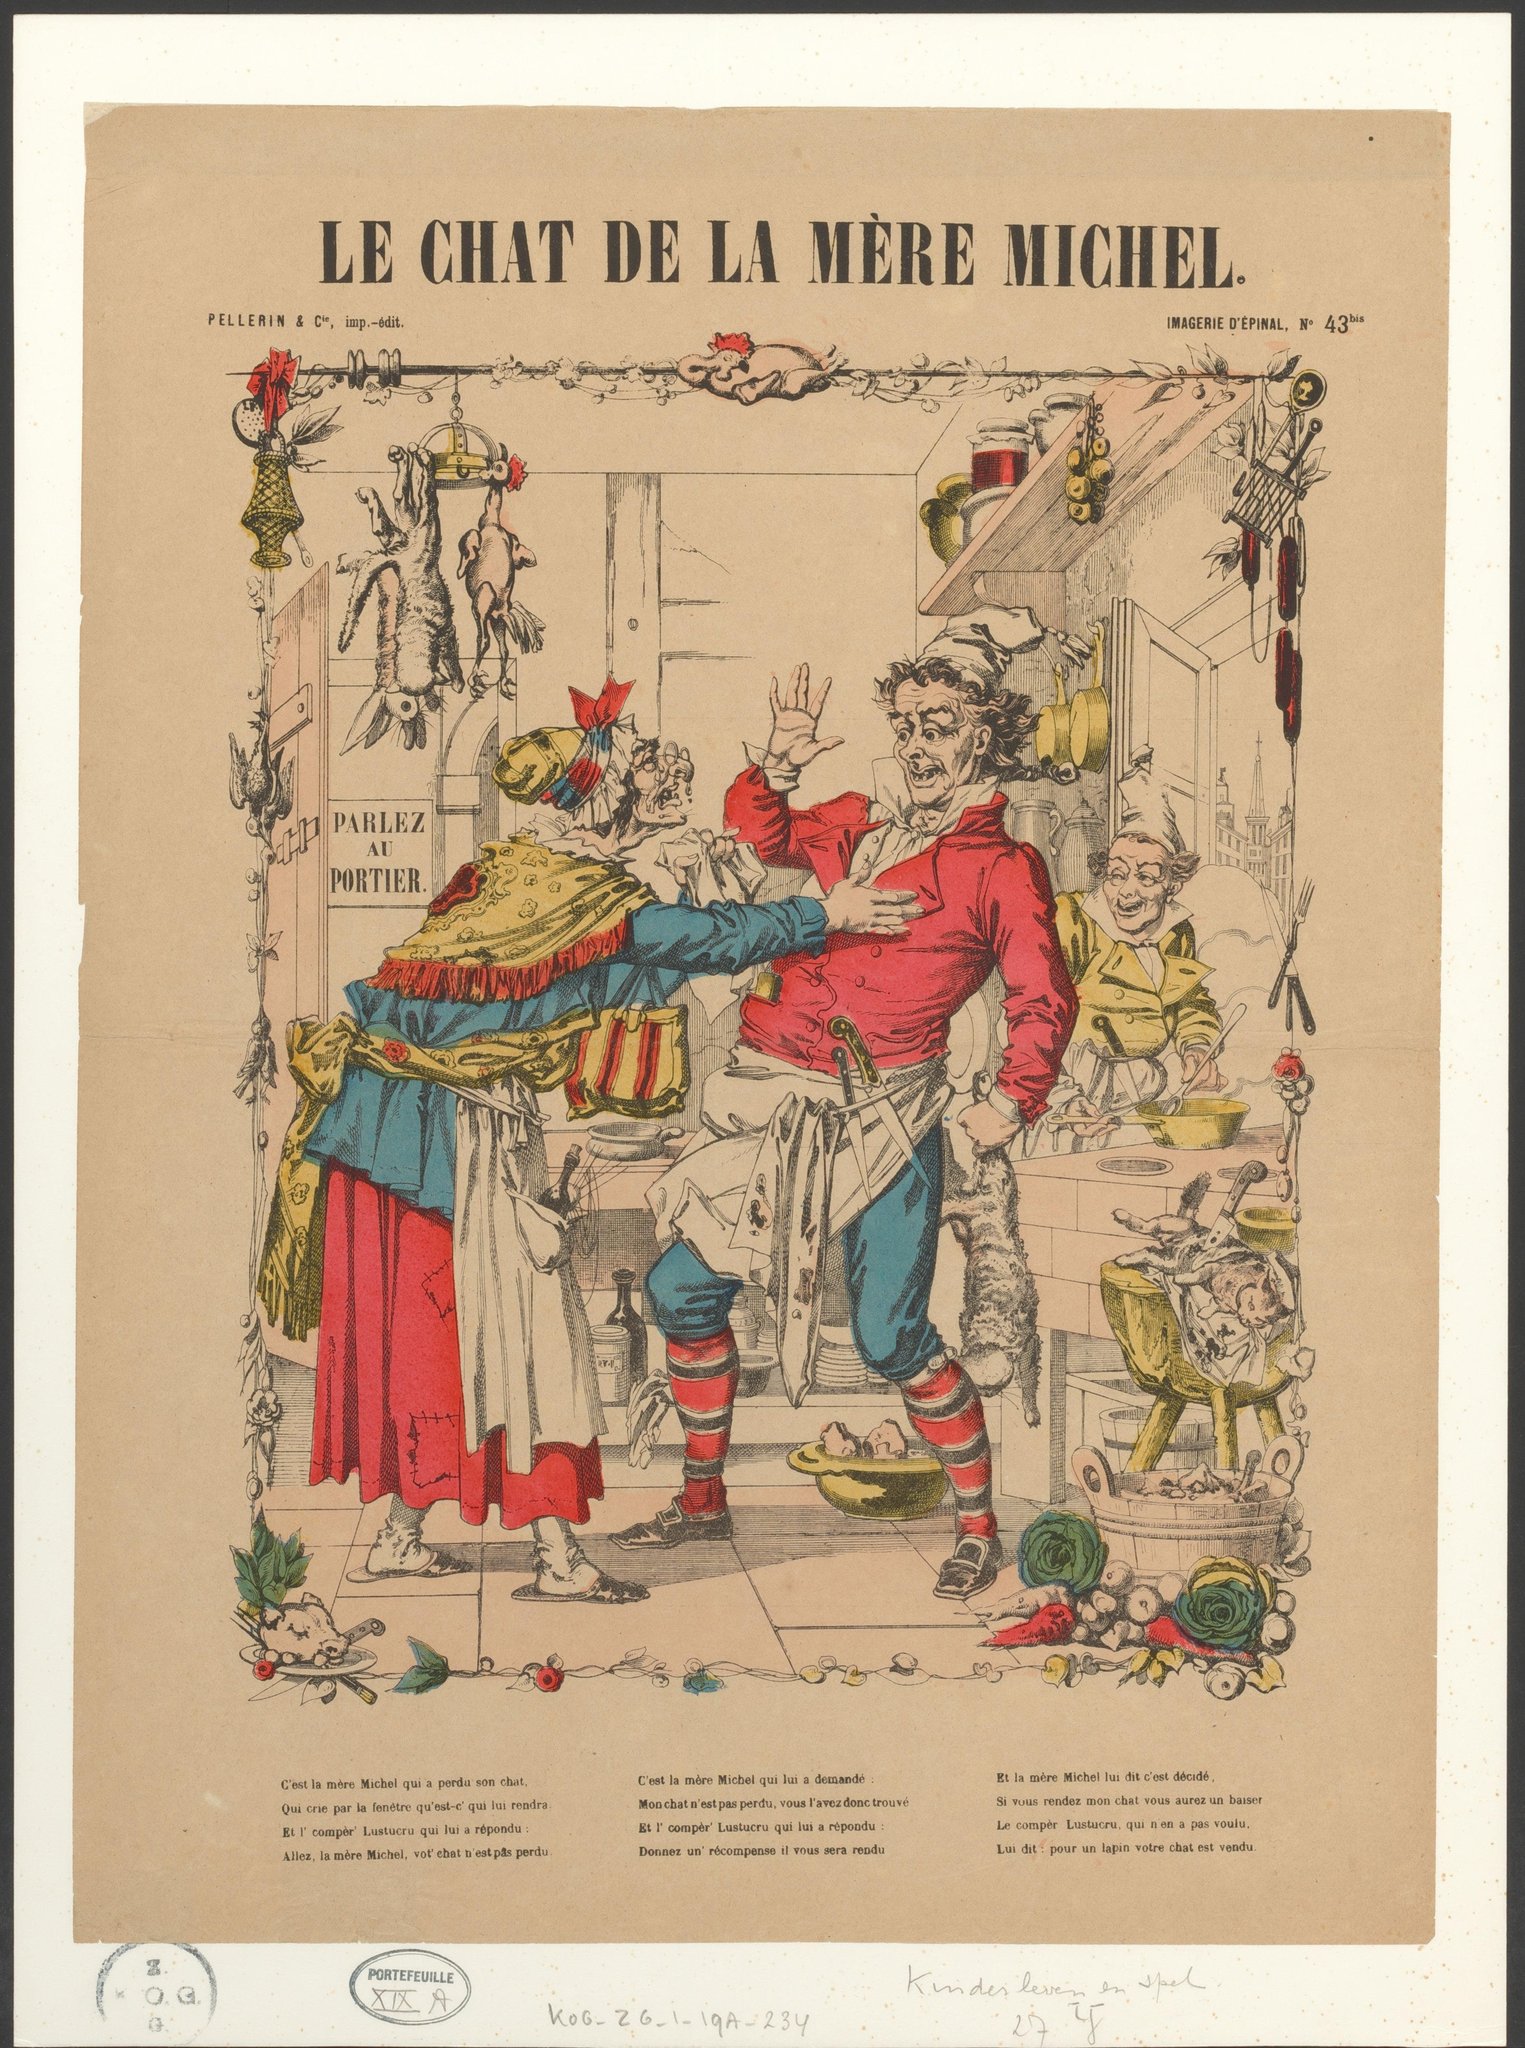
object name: print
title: Le chat de la mère Michel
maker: Anonymous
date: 1800-1900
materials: paper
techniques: hand coloring, lithograph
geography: epinal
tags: kitchen, cat, cook, weeping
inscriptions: collector's mark: Lugt 1641, stamp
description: Huilende vrouw en smeekt een kok haar kat niet te koken. Onderaan een twaalfregelig vers in het Frans in drie kolommen. Rechtsboven genummerd: Bo 43bis. Onderwerpsrubrieken binnen de Atlas Zeden en Gewoonten: Zeden en Gewoonten in Engeren Zin, Des menschen beging, midden en einde, Kinderleven – Kinderspel en Kinderprenten.